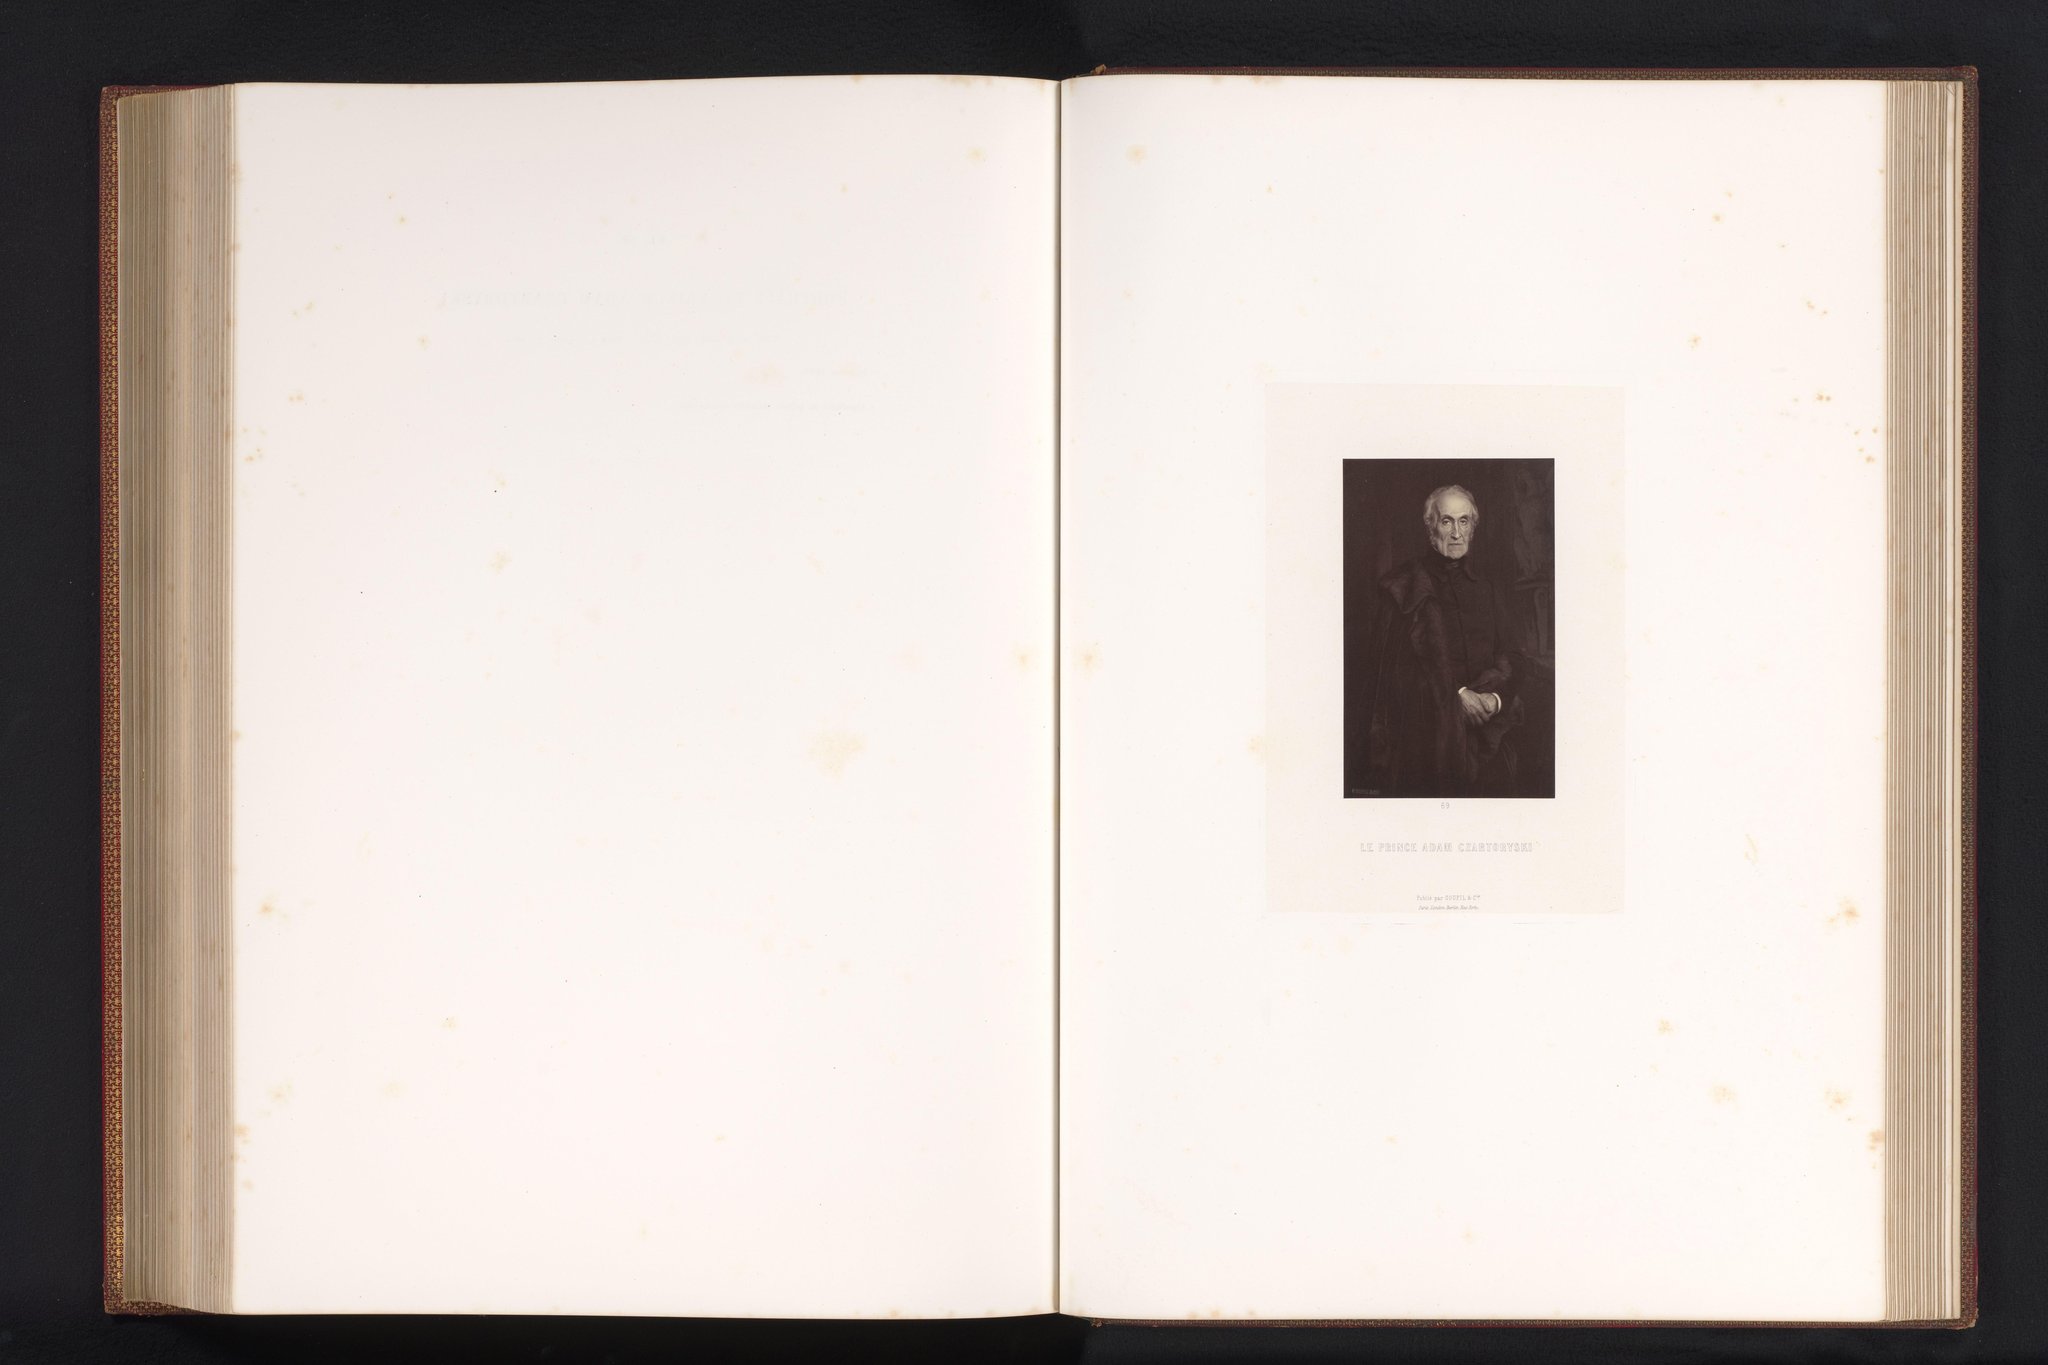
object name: photograph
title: Fotoreproductie van een geschilderd portret van Adam Jerzy Czartoryski door Paul Delaroche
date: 1853-1858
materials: paper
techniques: albumen print, engraving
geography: paris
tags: adam jerzy czartoryski, historical persons, diplomacy, diplomat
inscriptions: check stamp: ‘Goupil & Cie’